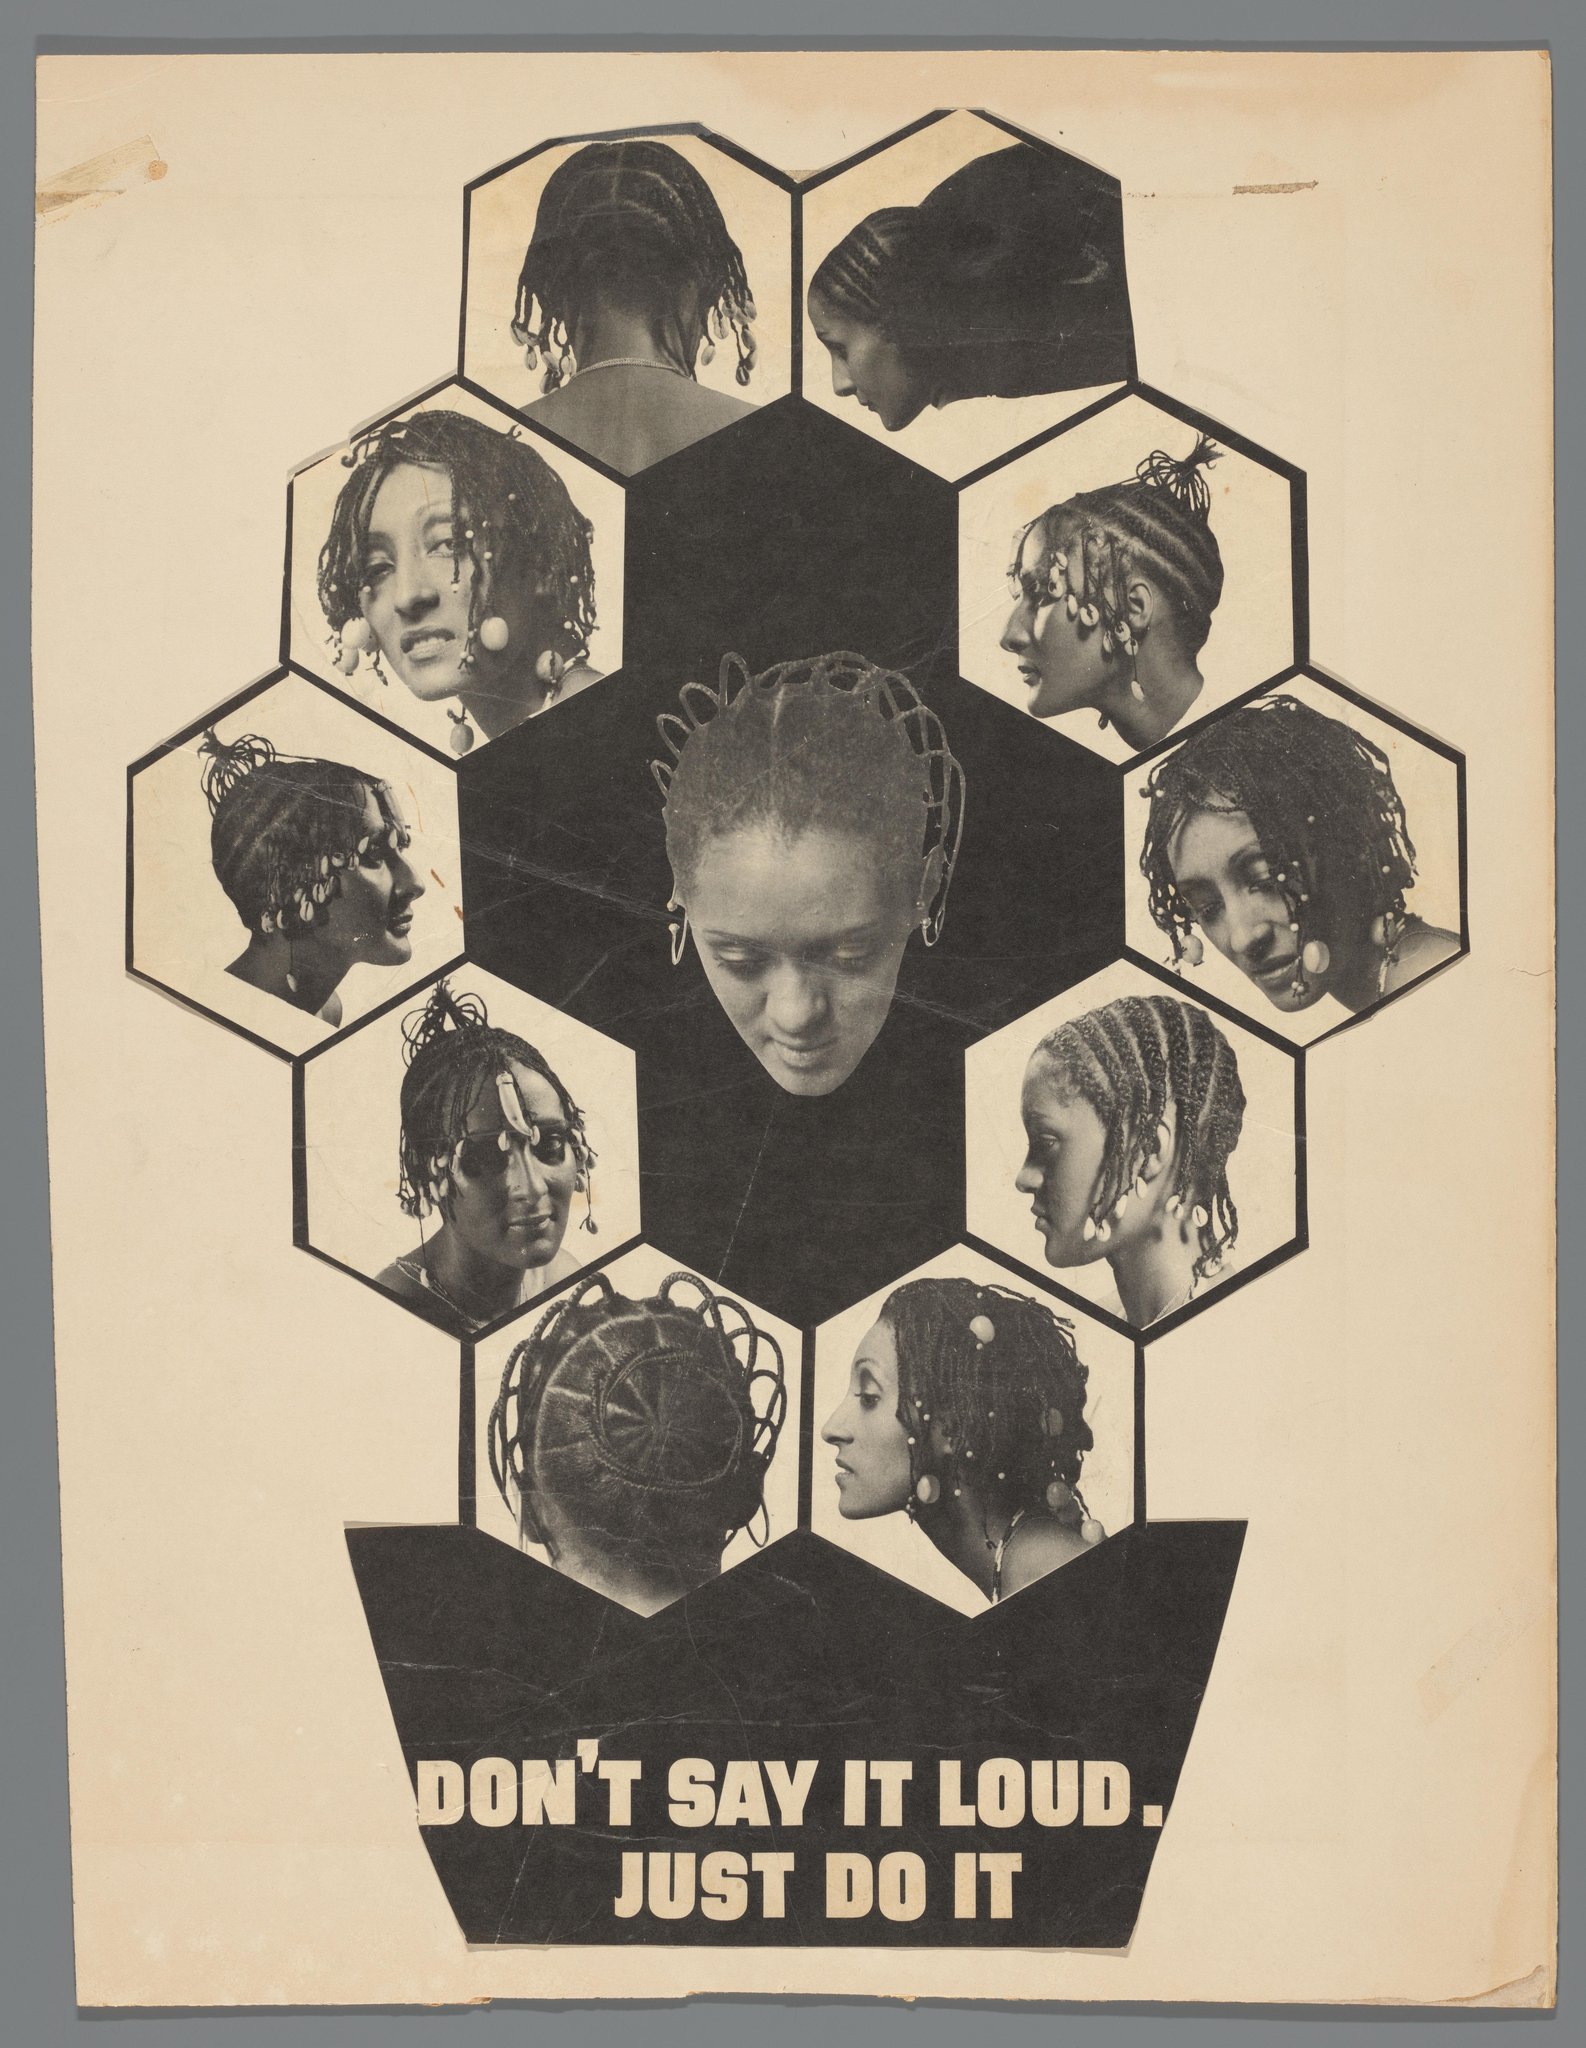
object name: photograph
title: Display foto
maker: Anonymous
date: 1980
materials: ink, paper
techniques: autotype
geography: united states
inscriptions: : ‘DON'T SAY IT LOUD. / JUST DO IT’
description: Advertentie (?) / displsay-materiaal voor een kapper(?).